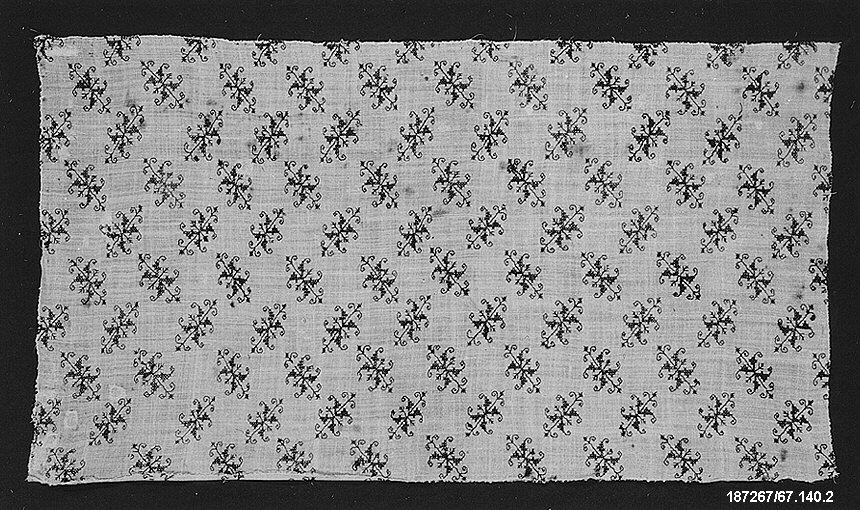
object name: piece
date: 1501-1700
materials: linen, silk